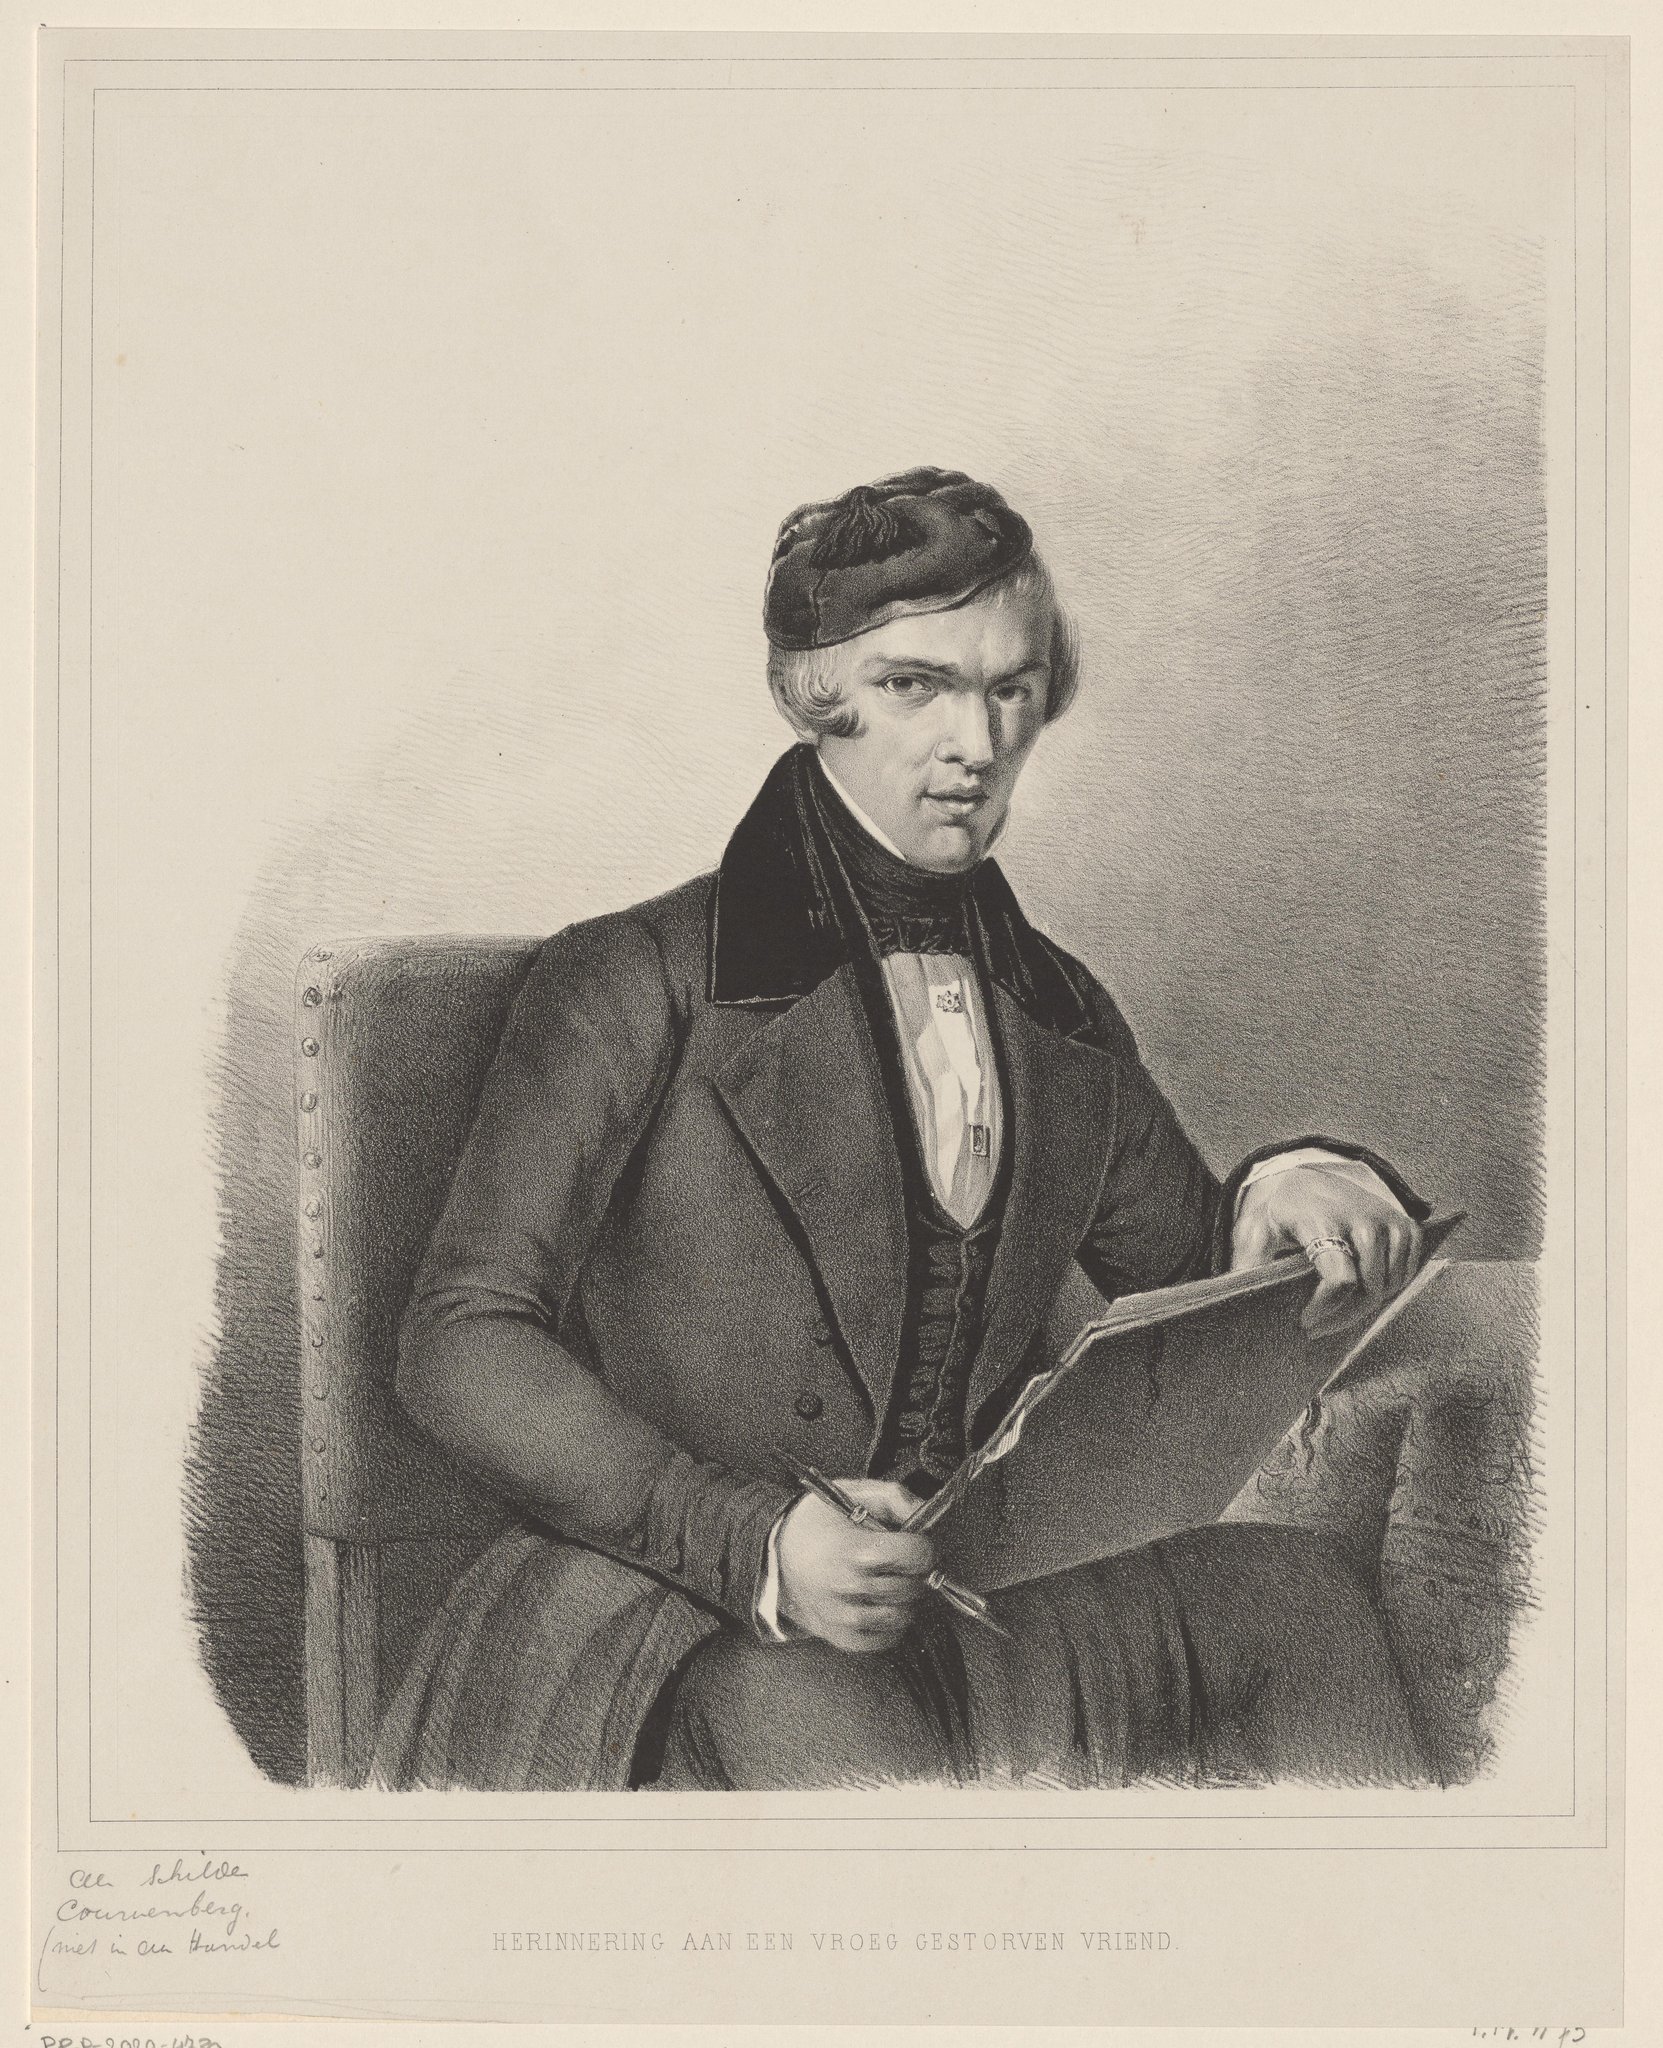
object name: print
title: Portret van Henricus Wilhelmus Couwenberg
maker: giovanni caramelli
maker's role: draughtsman, print maker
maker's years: 1816-1881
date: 1845-1857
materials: paper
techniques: lithograph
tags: the hague, amsterdam, print maker, draughtsman, henricus wilhelmus couwenberg, historical persons